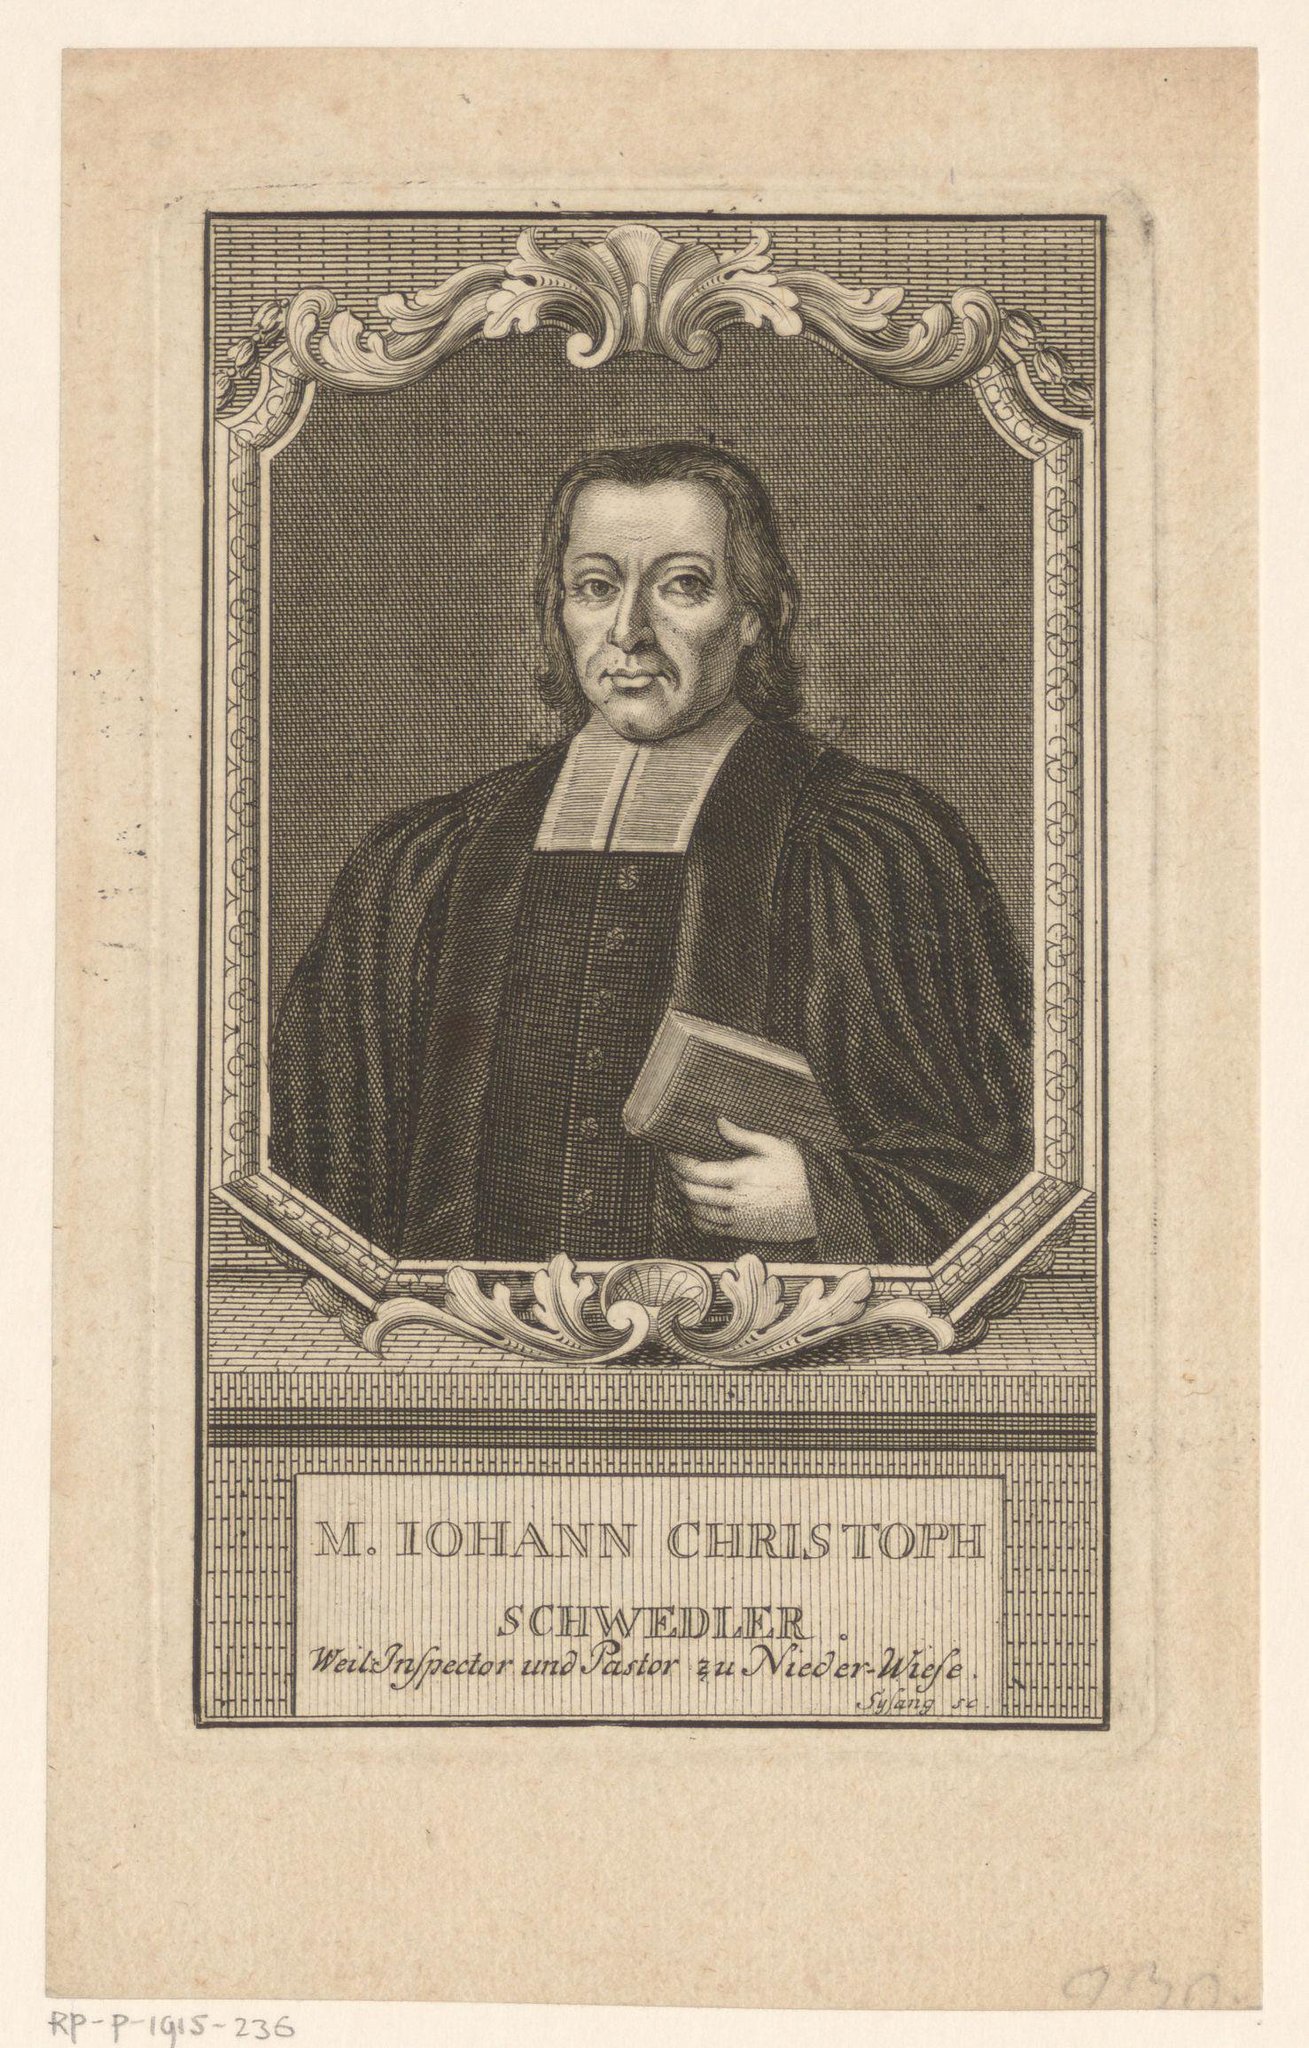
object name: print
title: Portret van Johann Christoph Schwedler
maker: johann christoph sysang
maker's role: print maker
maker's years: 1703-1757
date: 1713-1757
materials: paper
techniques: engraving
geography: germany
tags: historical persons, book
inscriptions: collector's mark: Lugt 2228